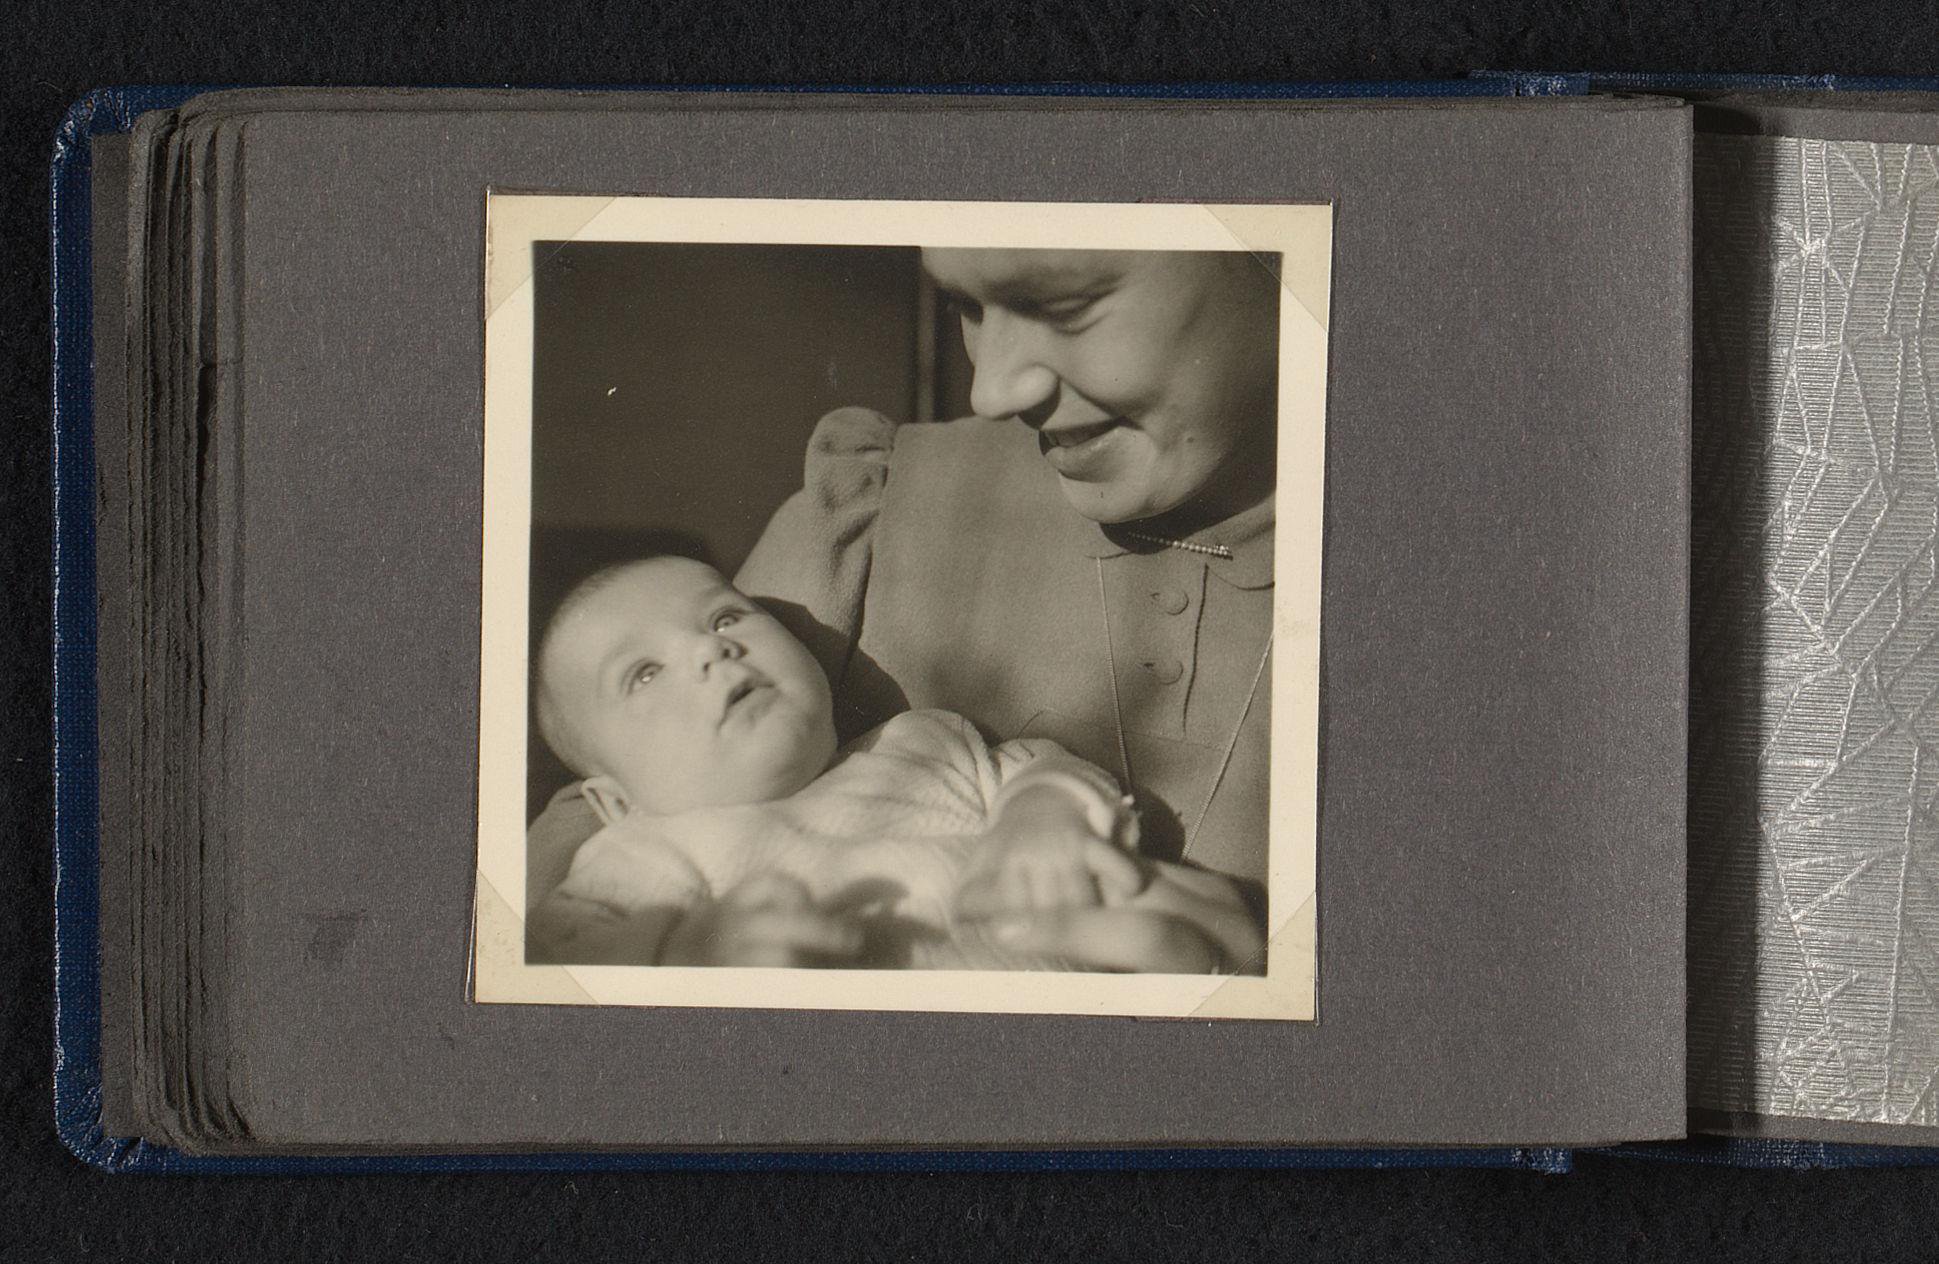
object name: album leaf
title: Maria Louise van den Berg-Halbertsma met pasgeboren zoon Norbert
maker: norbert peter van den berg (1941-)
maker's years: 1941-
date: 1941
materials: paper, cardboard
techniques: gelatin silver print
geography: netherlands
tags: norbert peter van den berg (1941-), rotterdam, maria louise van den berg-halbertsma, adult woman, infant, baby, other methods of carrying children